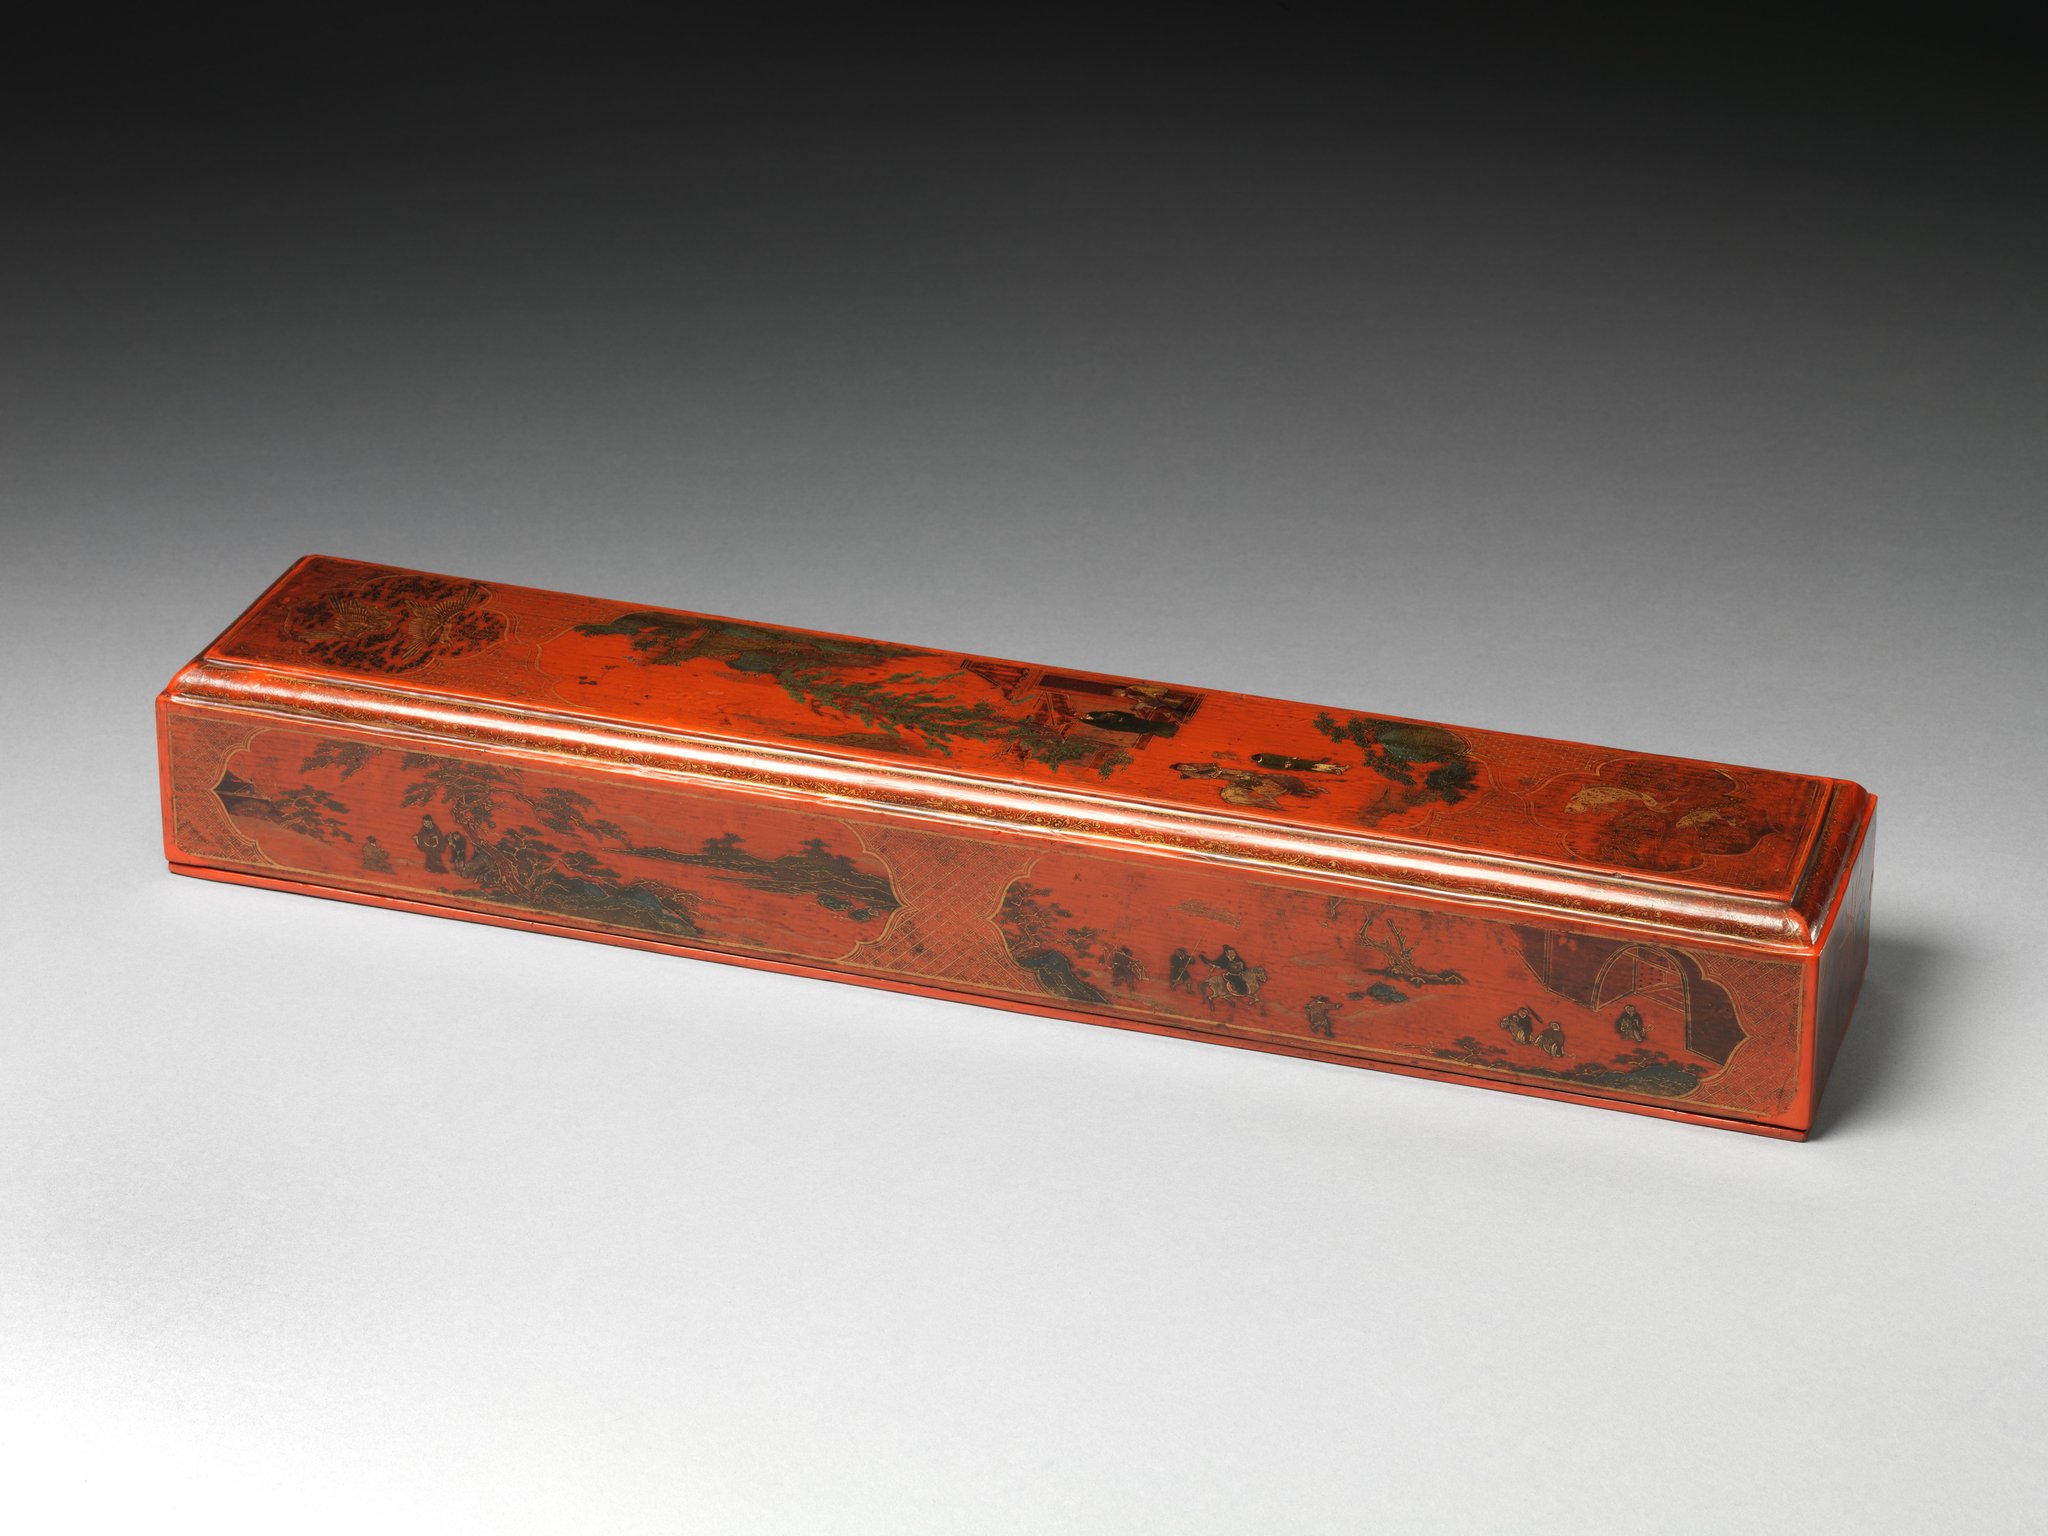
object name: box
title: Rectangular box with scene of a visit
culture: chinese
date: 1567-1633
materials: gold, lacquer, oil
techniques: painting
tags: horses,trees